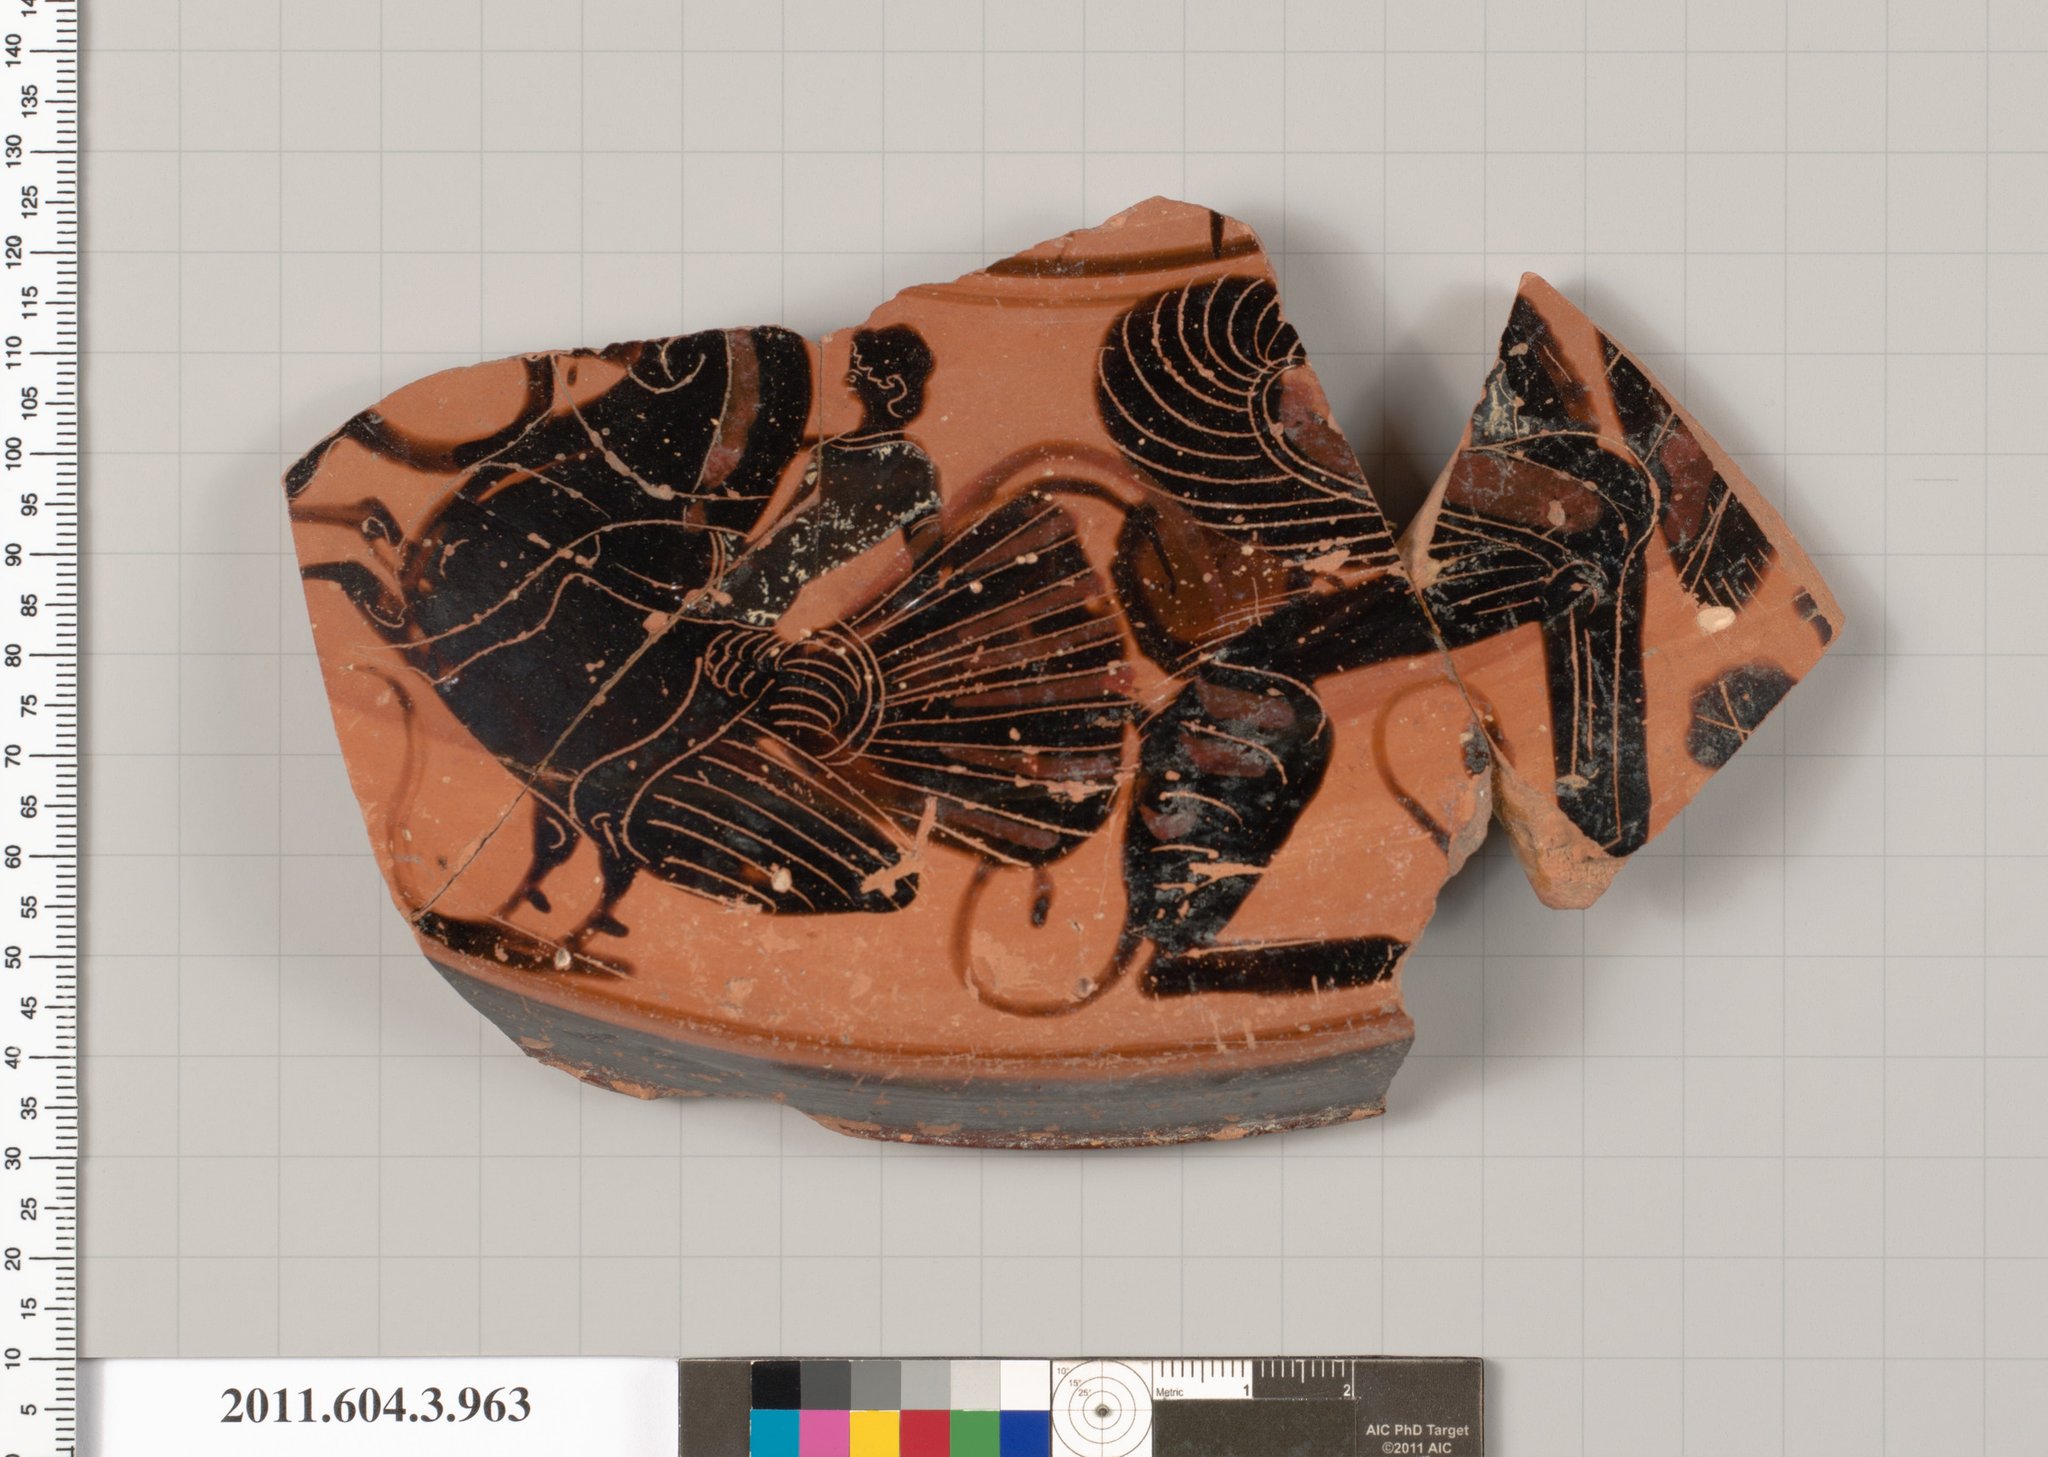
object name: lekanis lid fragment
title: Terracotta fragment of a lekanis lid (covered dish)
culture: greek, attic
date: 575-551 BCE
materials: terracotta